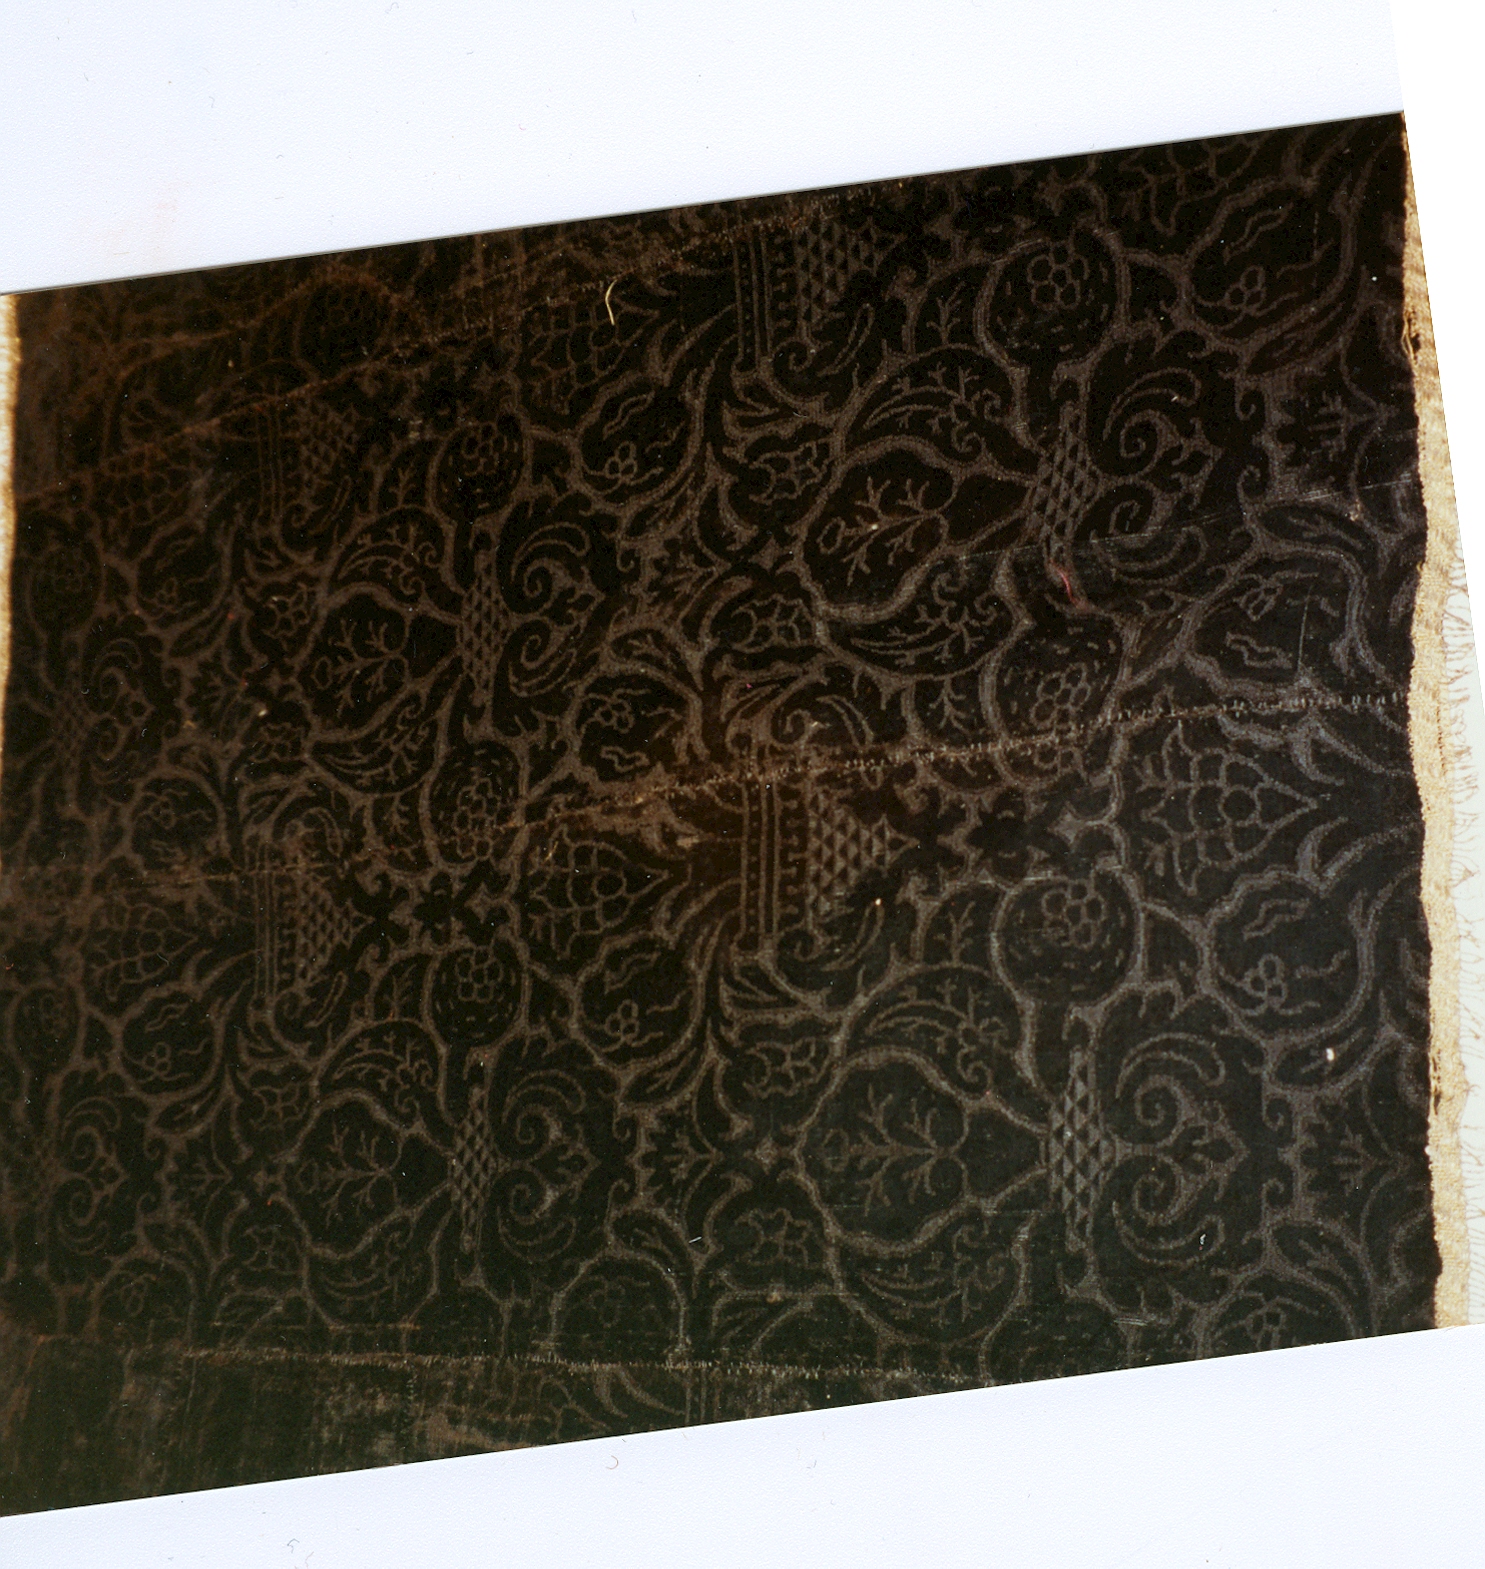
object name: textile cover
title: cover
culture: italian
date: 1601-1700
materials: metal, silk